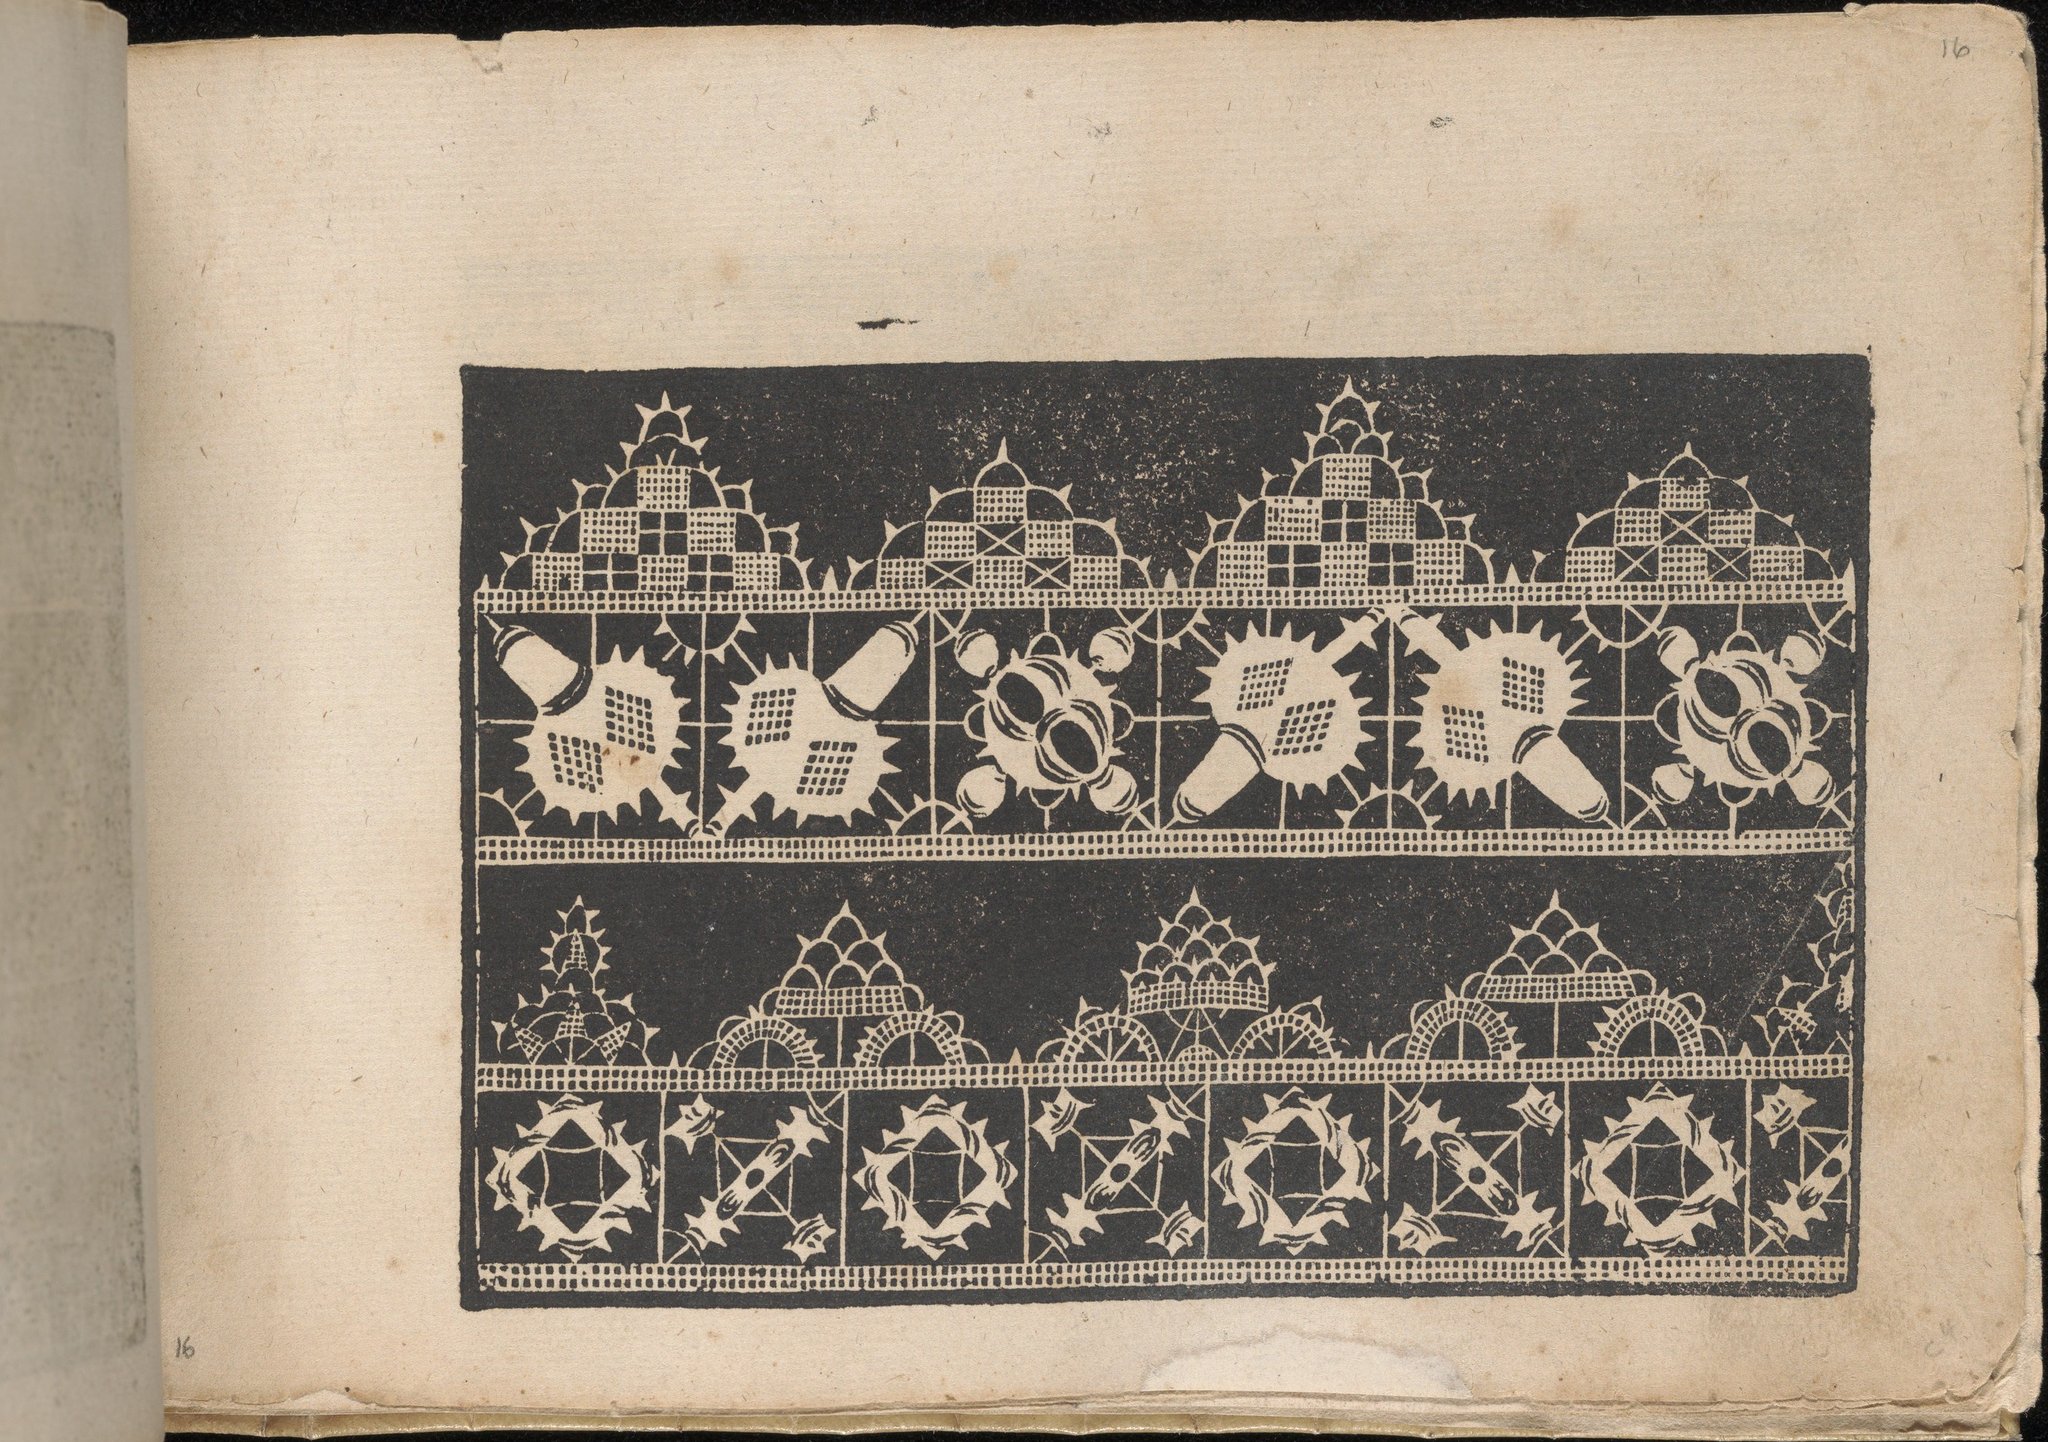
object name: book print ornament archiecture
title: Fiori di Ricami Nuovamente Posti in Luce, page 16 (recto)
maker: matteo florimi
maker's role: designer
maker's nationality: italian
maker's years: 1581-1613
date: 1591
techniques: woodcut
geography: italy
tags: ornament